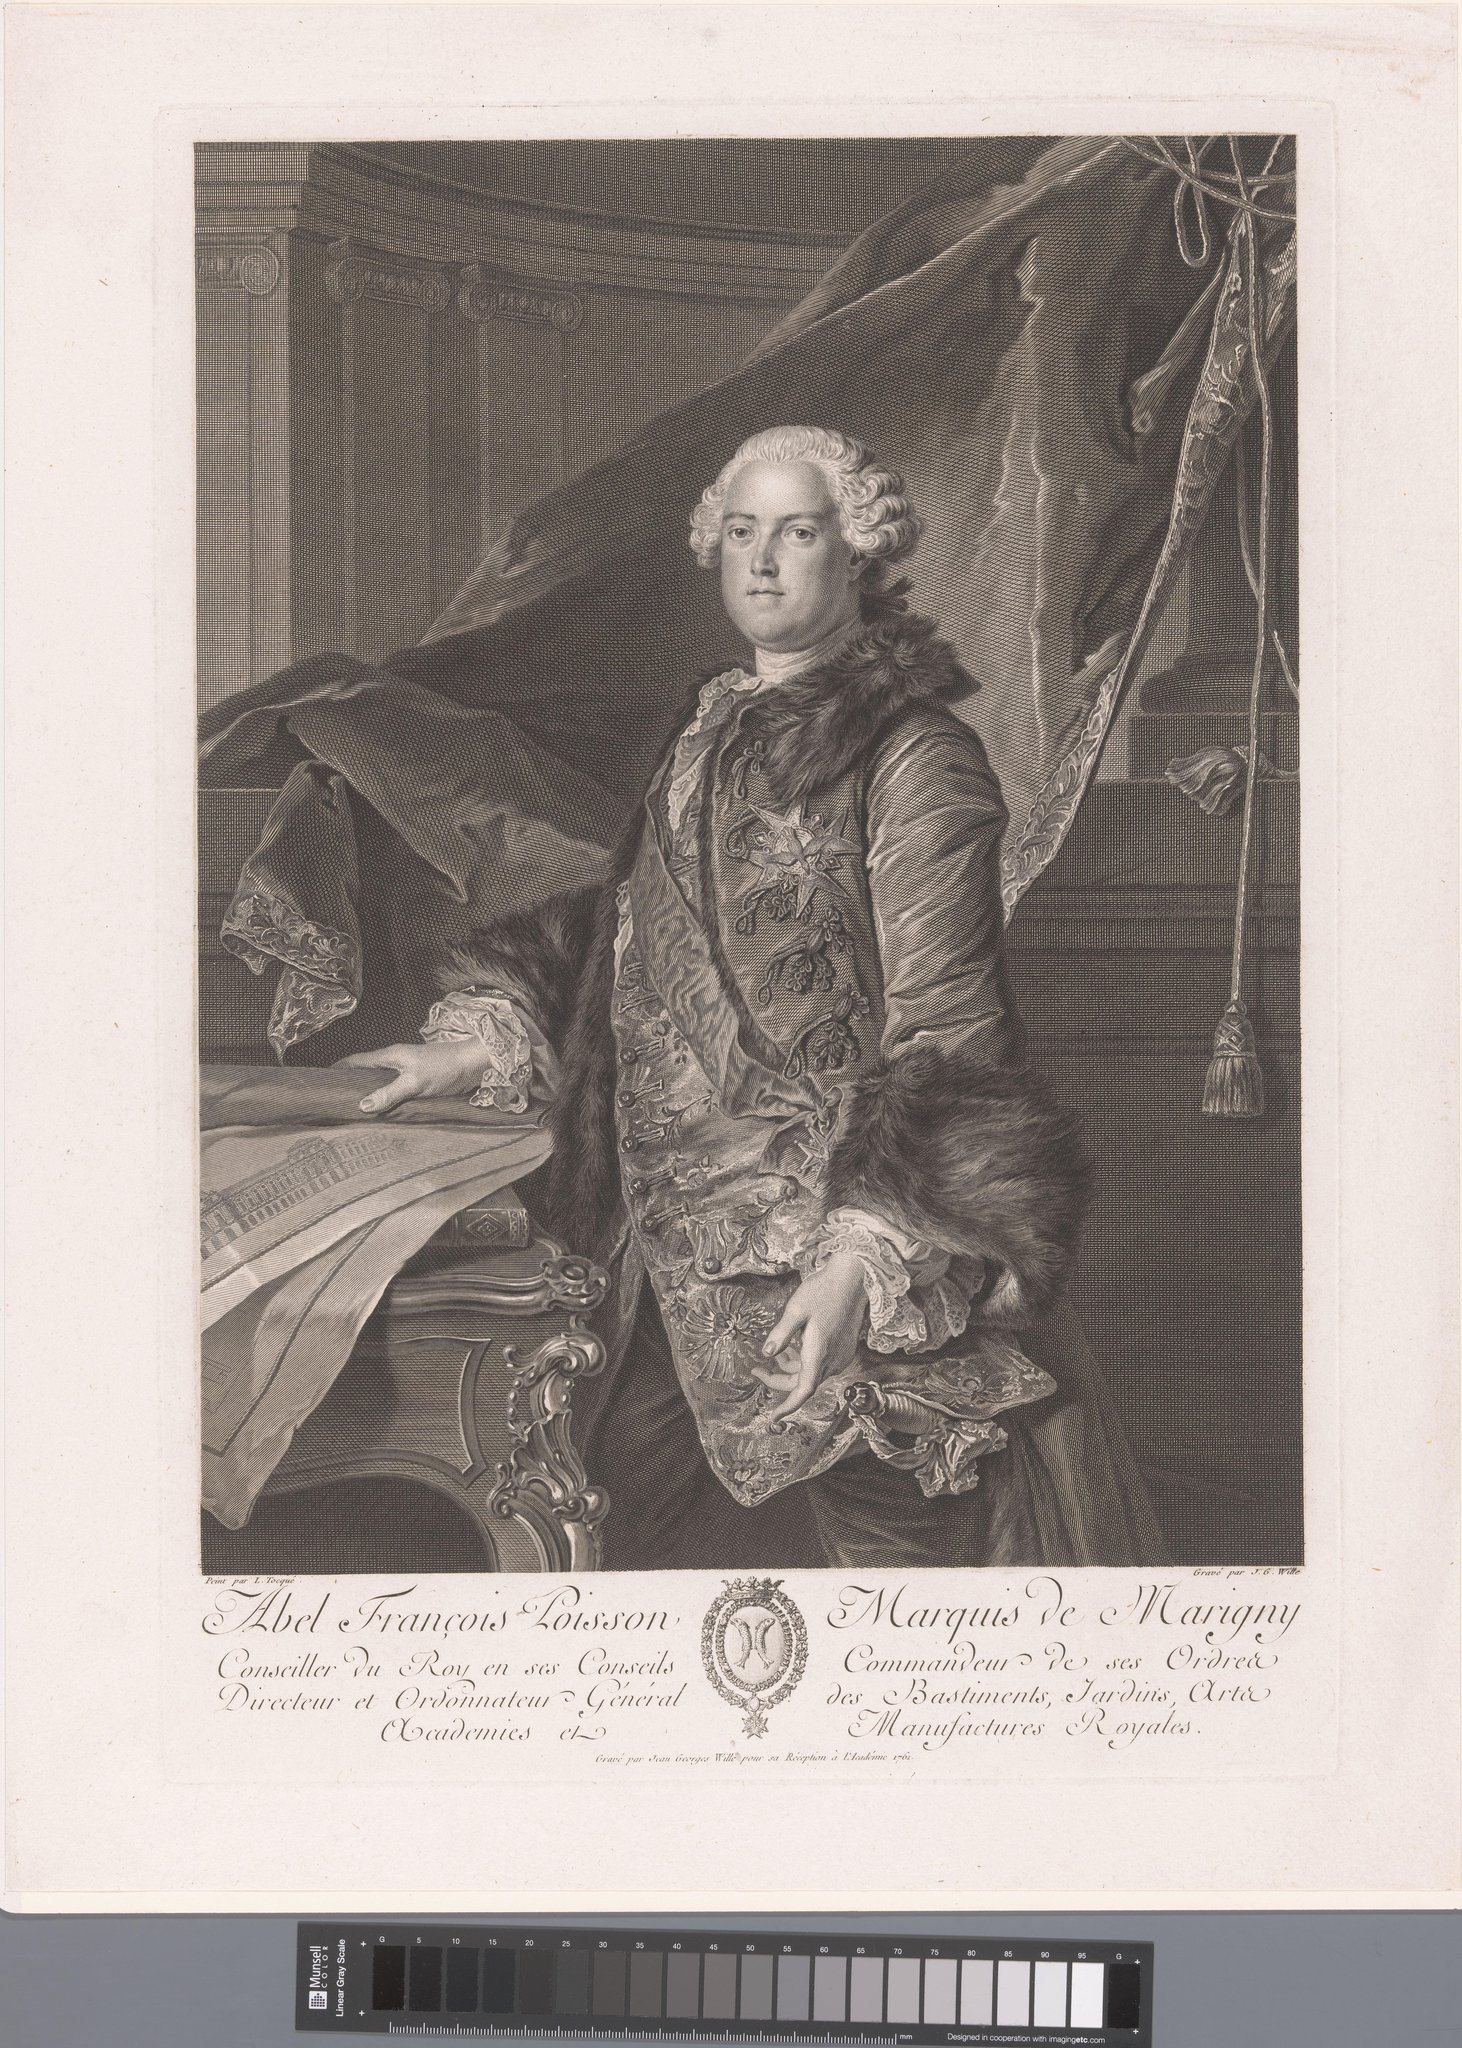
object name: print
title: Portret van Abel François Poisson, marquis de Marigny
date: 1761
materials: paper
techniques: engraving, etching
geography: france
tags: paris, abel françois poisson de vandières (marquis de marigny), historical persons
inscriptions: collector's mark: Lugt 240